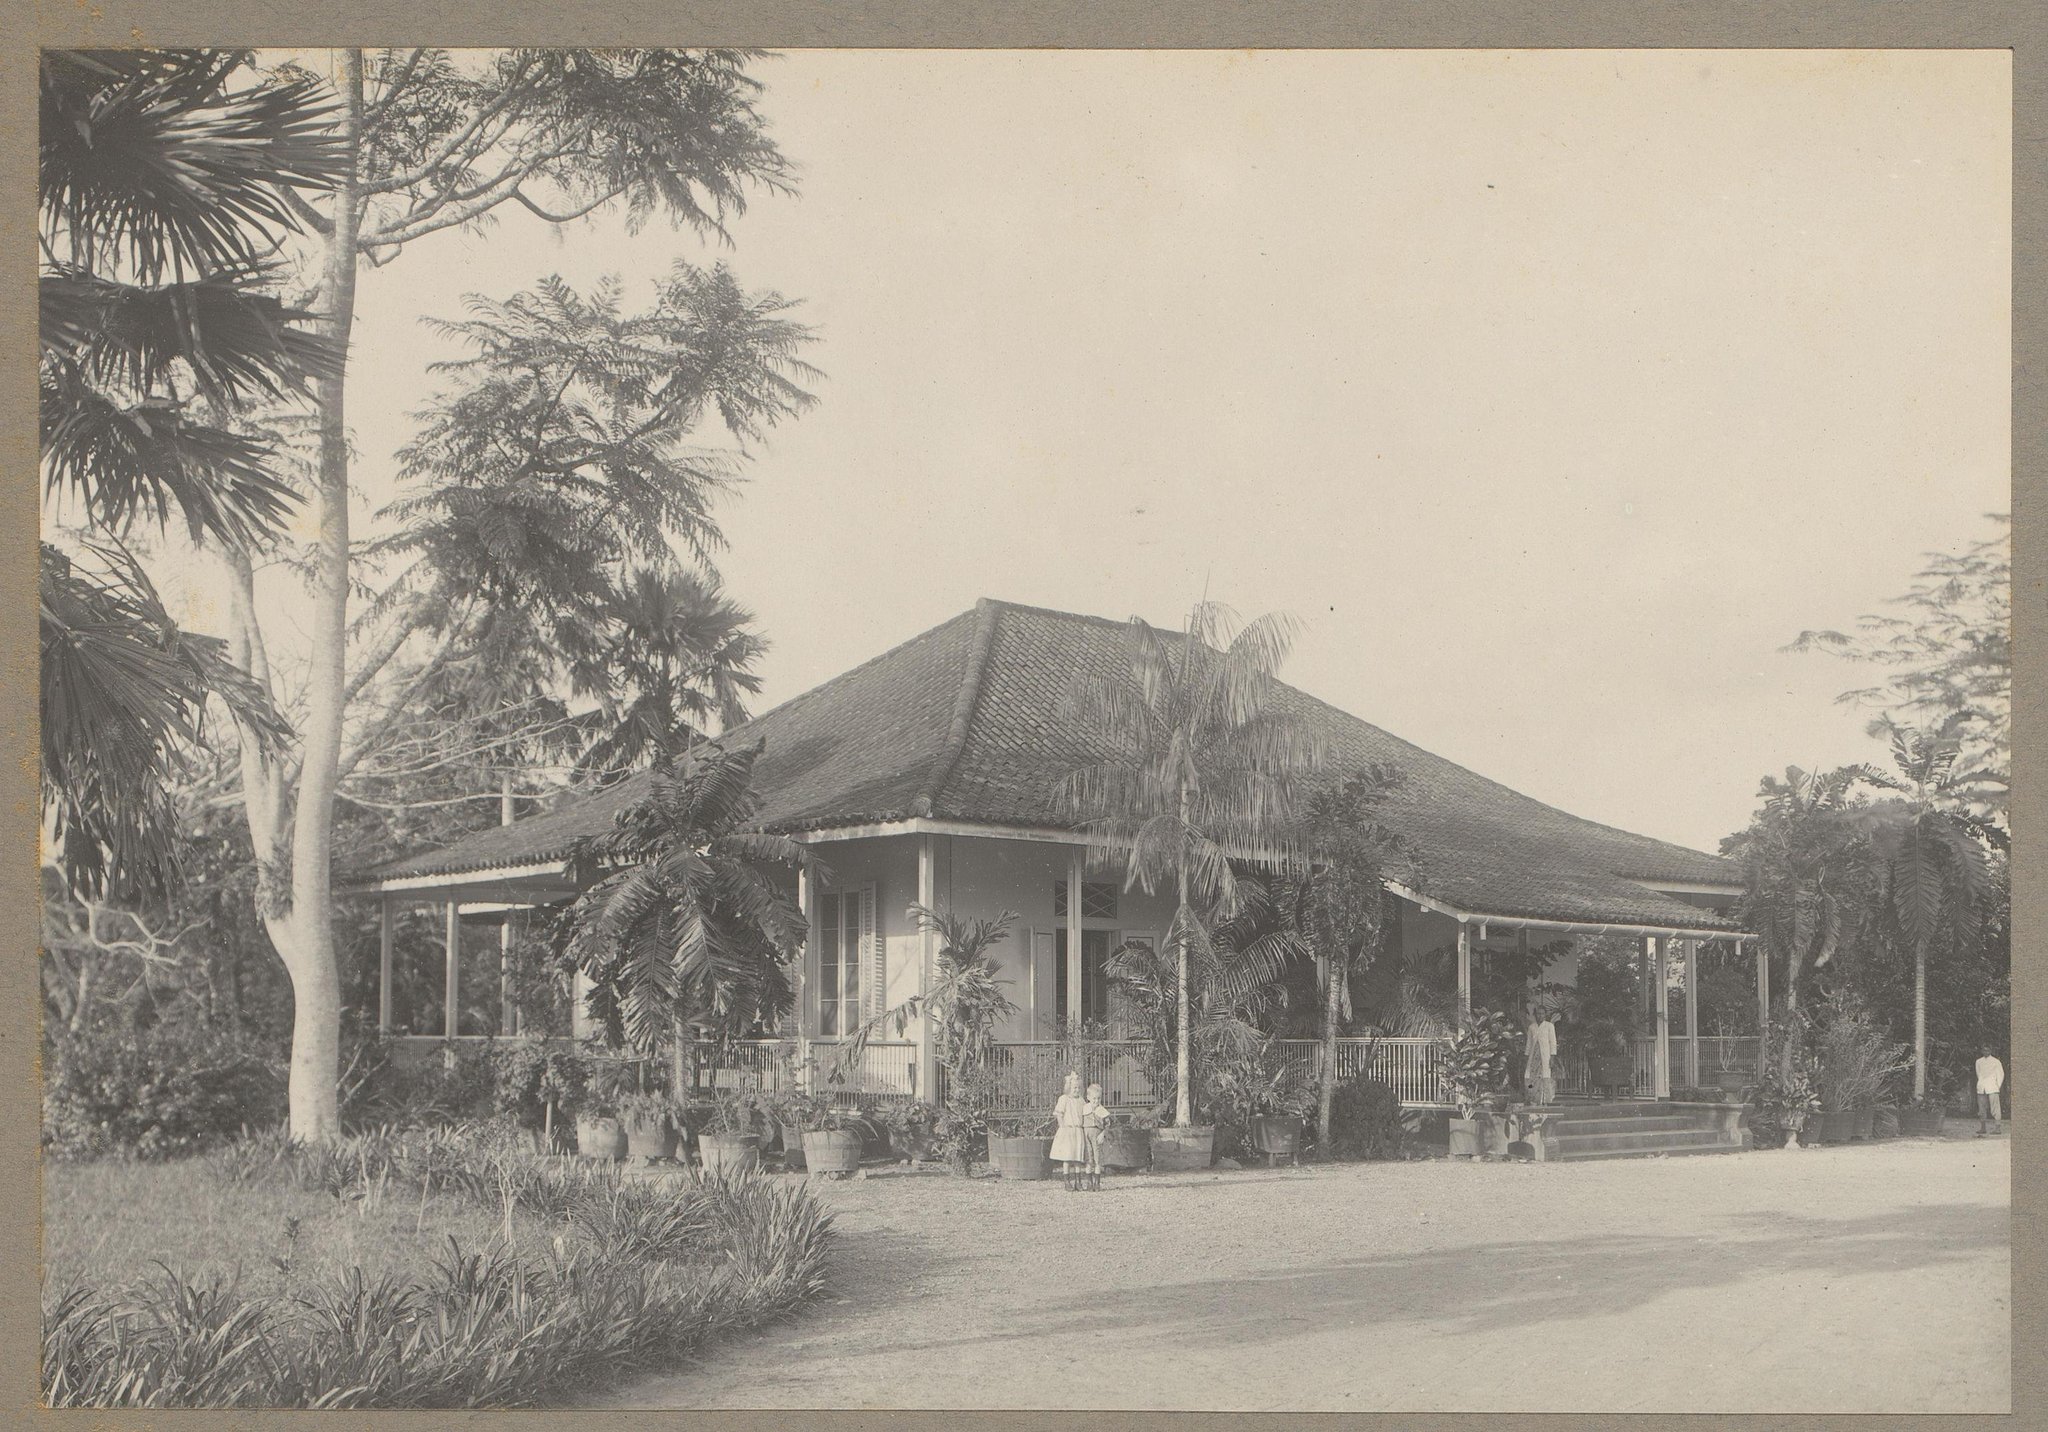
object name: photograph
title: Pangkalpinang. Woning van den Sectie-Chef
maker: Anonymous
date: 1914-1919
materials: photographic support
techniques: gelatin silver print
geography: bangka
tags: robert julius boers, colonial system, mining, villa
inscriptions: inscription: ‘Pangkalpinang. Woning van den Sectie-Chef’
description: Woning van de Sectie-Chef van de Banka-tinwinning te Pangkalpinang. Voor het huis twee kinderen en twee leden huispersoneel. Onderdeel van het fotoalbum aangeboden aan Robert Julius Boers bij zijn vertrek naar Nederland in 1919 door het personeel van de Banka-tinwinning.